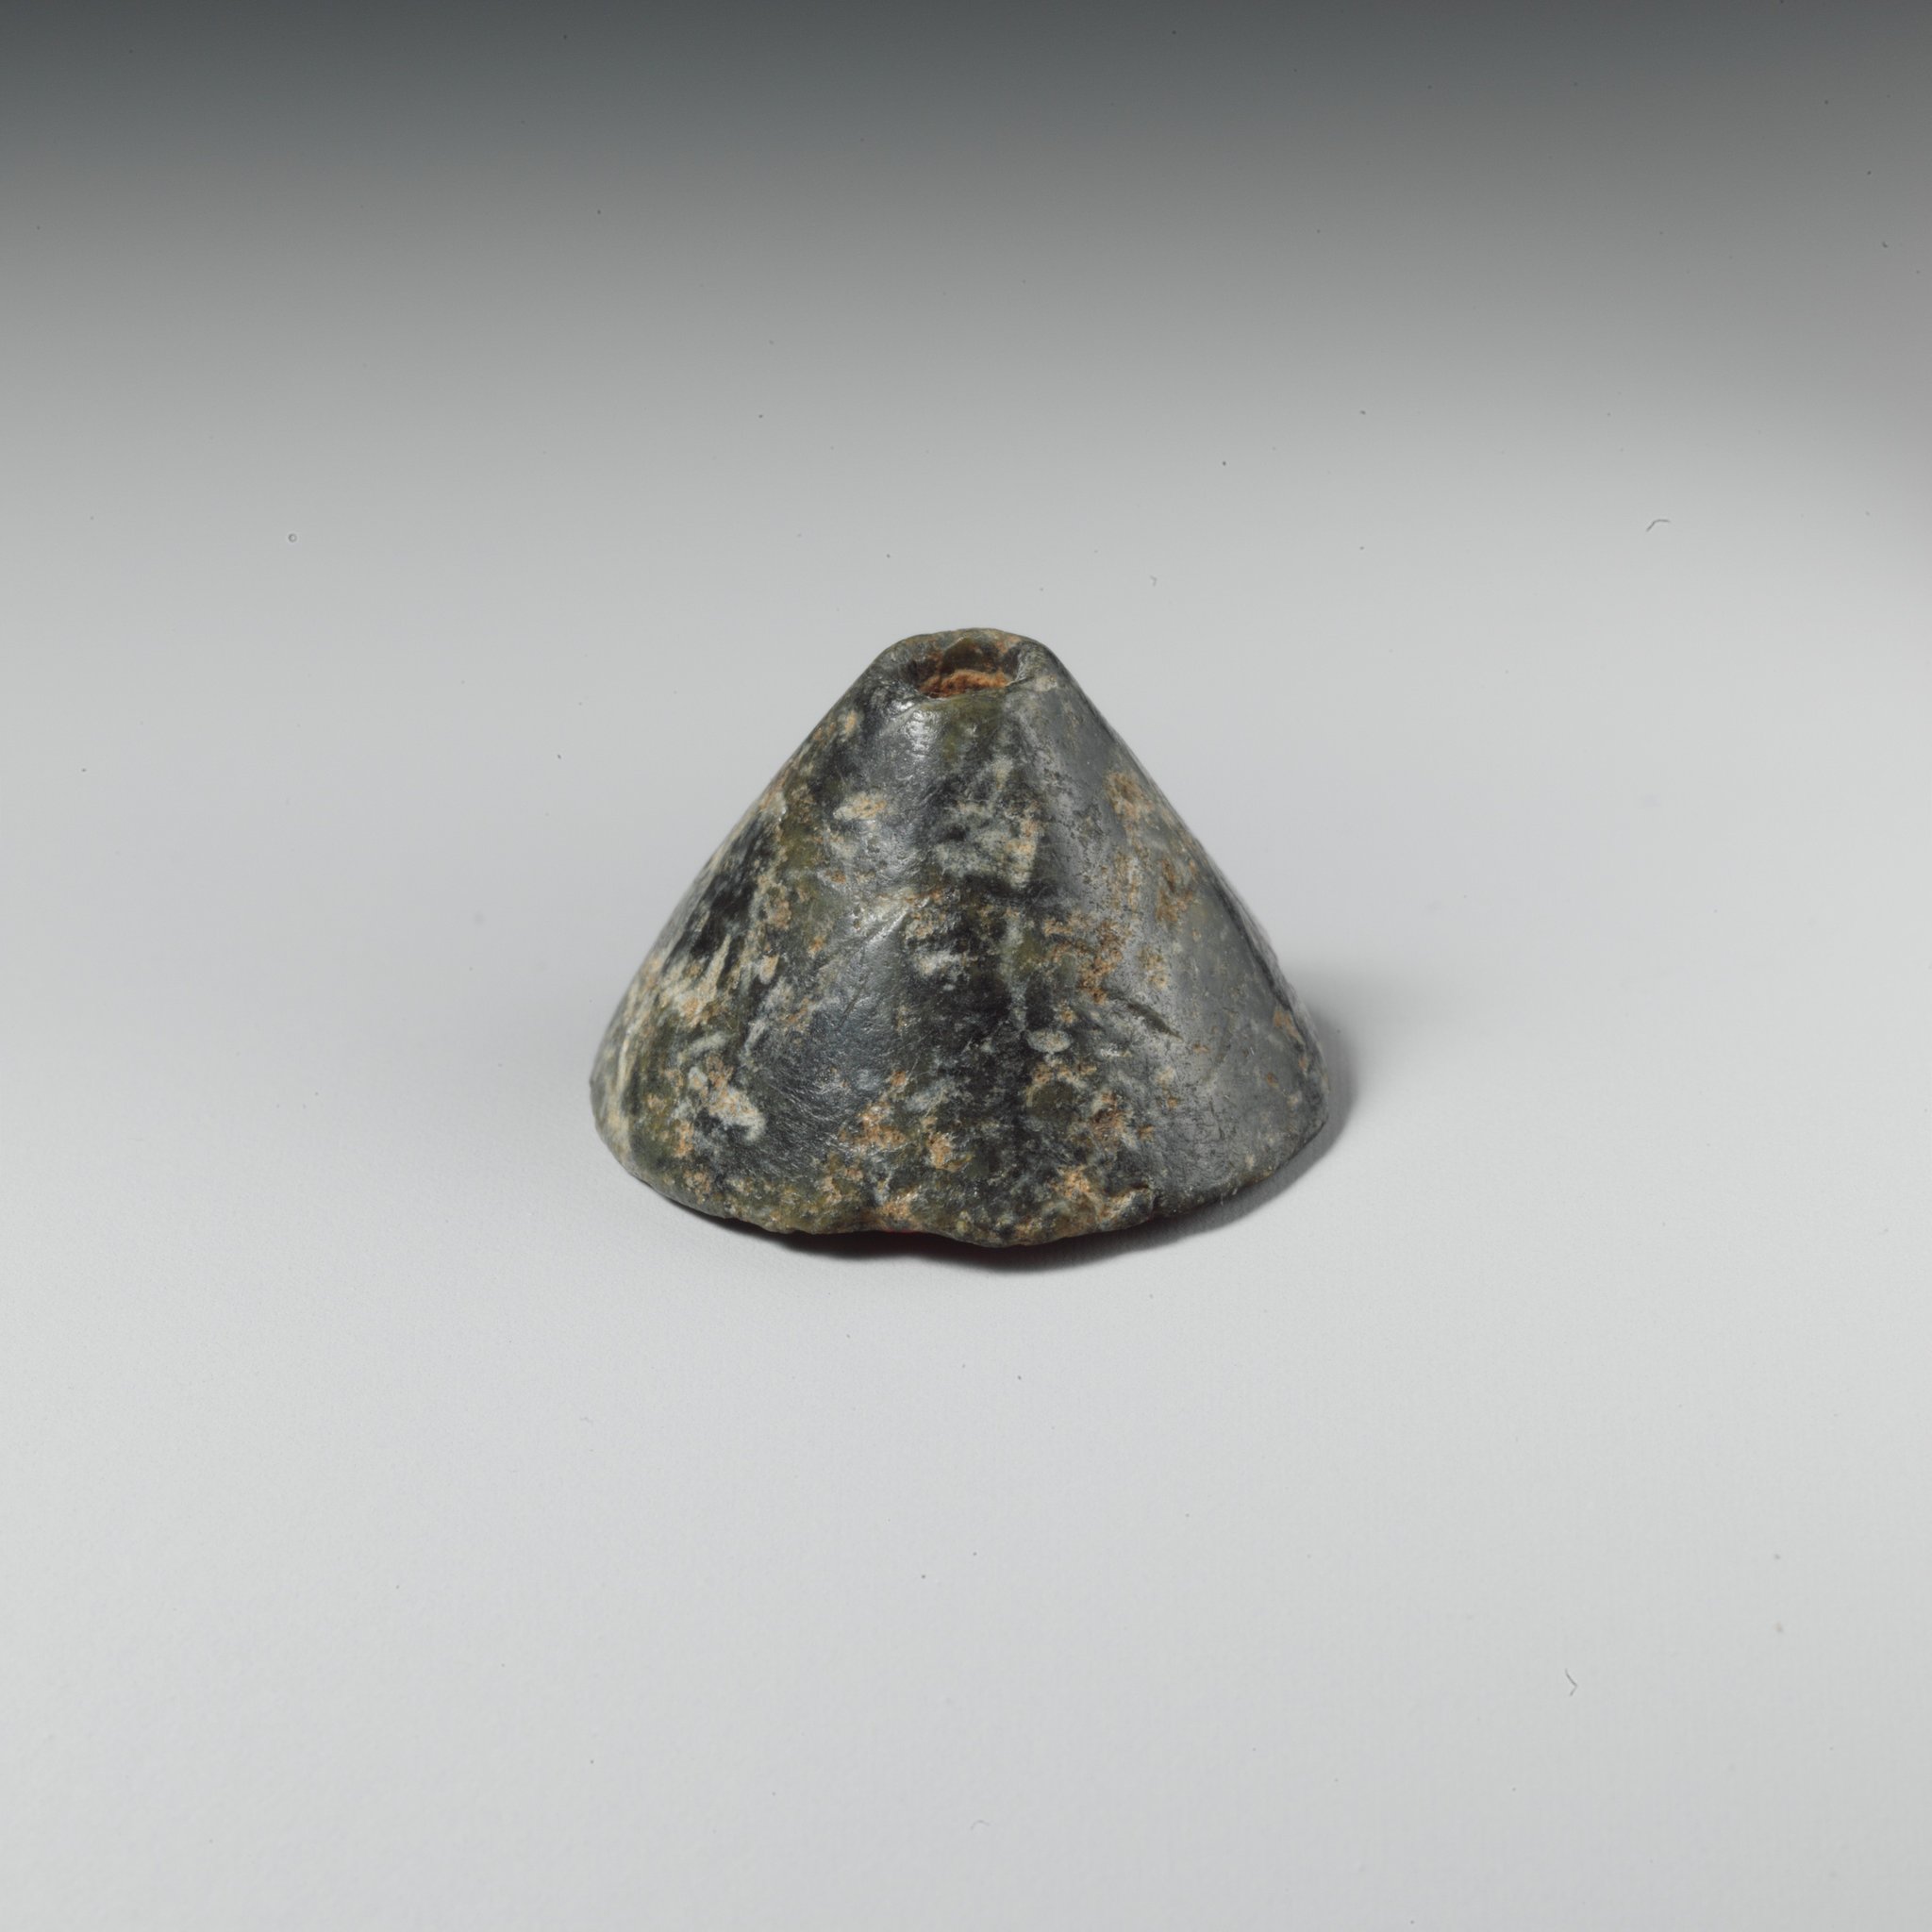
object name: spindle whorl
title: Steatite spindle whorl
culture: minoan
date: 2400-1450 BCE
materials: stone